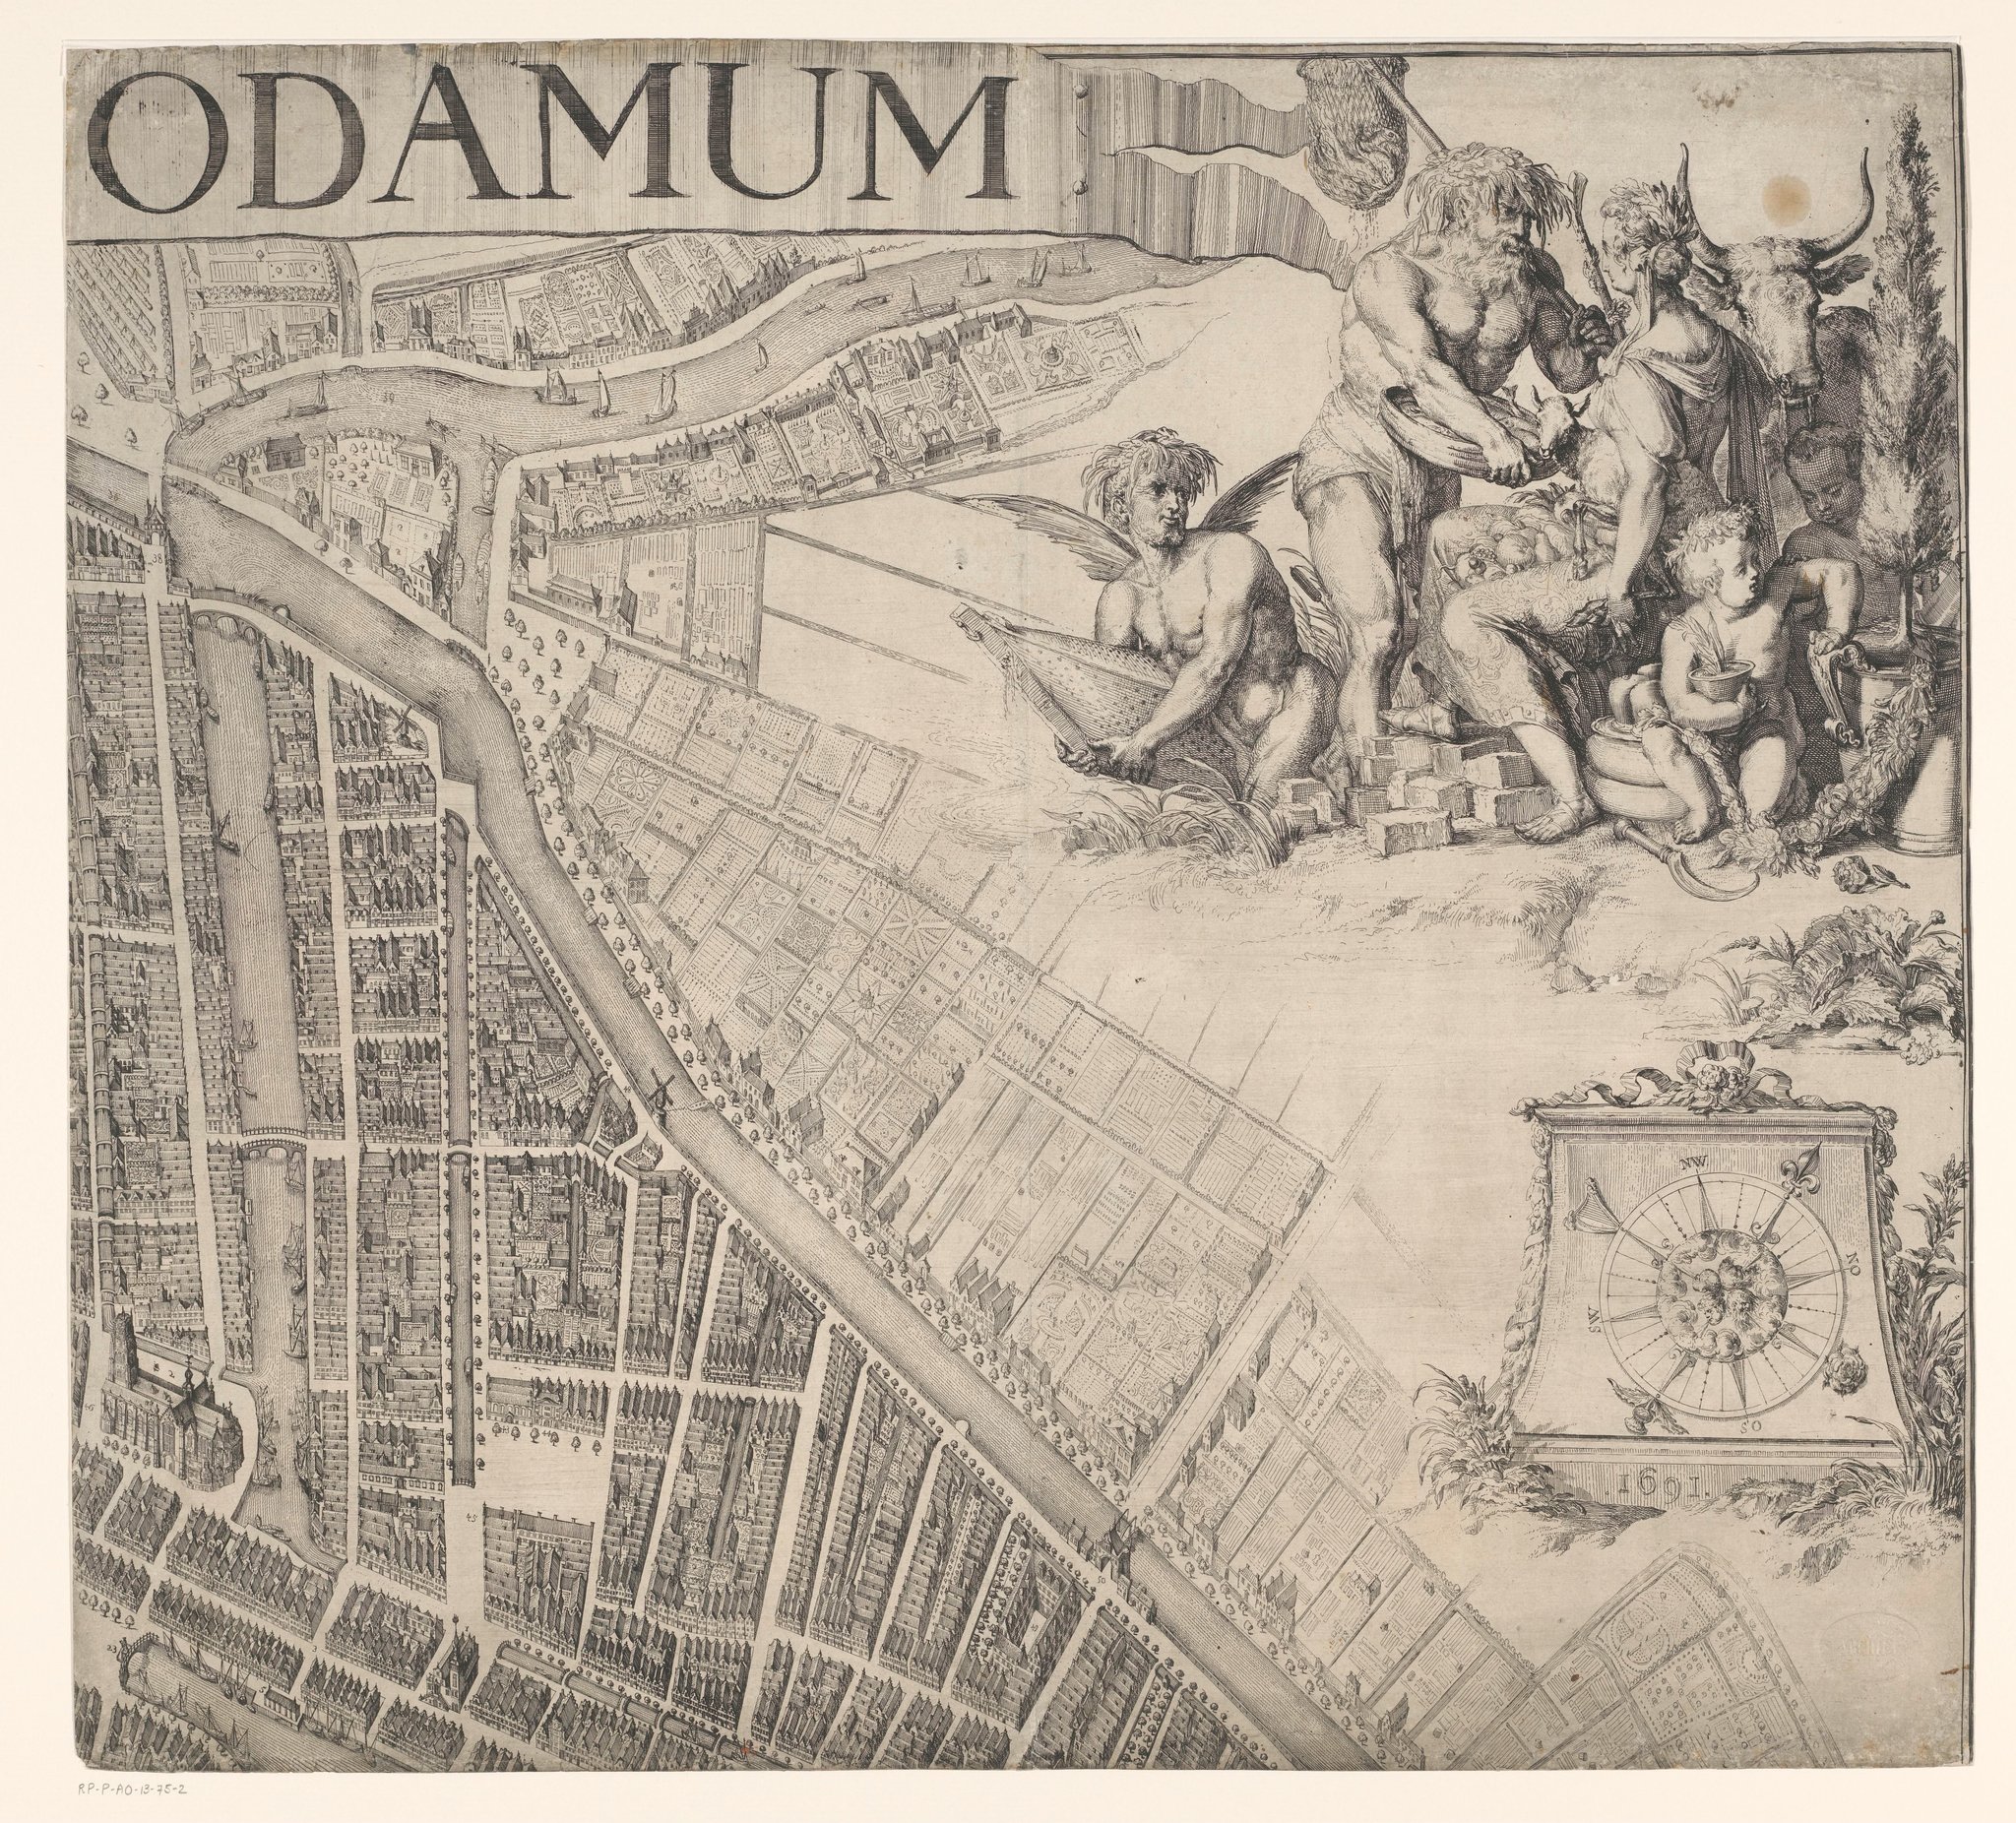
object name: area plan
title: Plattegrond van Rotterdam (deel rechtsboven)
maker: romeyn de hooghe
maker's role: draughtsman, goldsmith, painter, print maker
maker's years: 1645-1708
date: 1691-1692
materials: ink, paper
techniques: brush, etching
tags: commercial fishery, (story of) ceres (demeter), peat-cutting, triton(s), river-gods, agriculture, maps of cities, rotterdam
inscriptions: check stamp: ‘Archief Ministerie van Oorlog Afdeeling Genie’, collector's mark: Lugt 2228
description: Deel (rechtsboven) van een vierdelige plattegrond van Rotterdam.